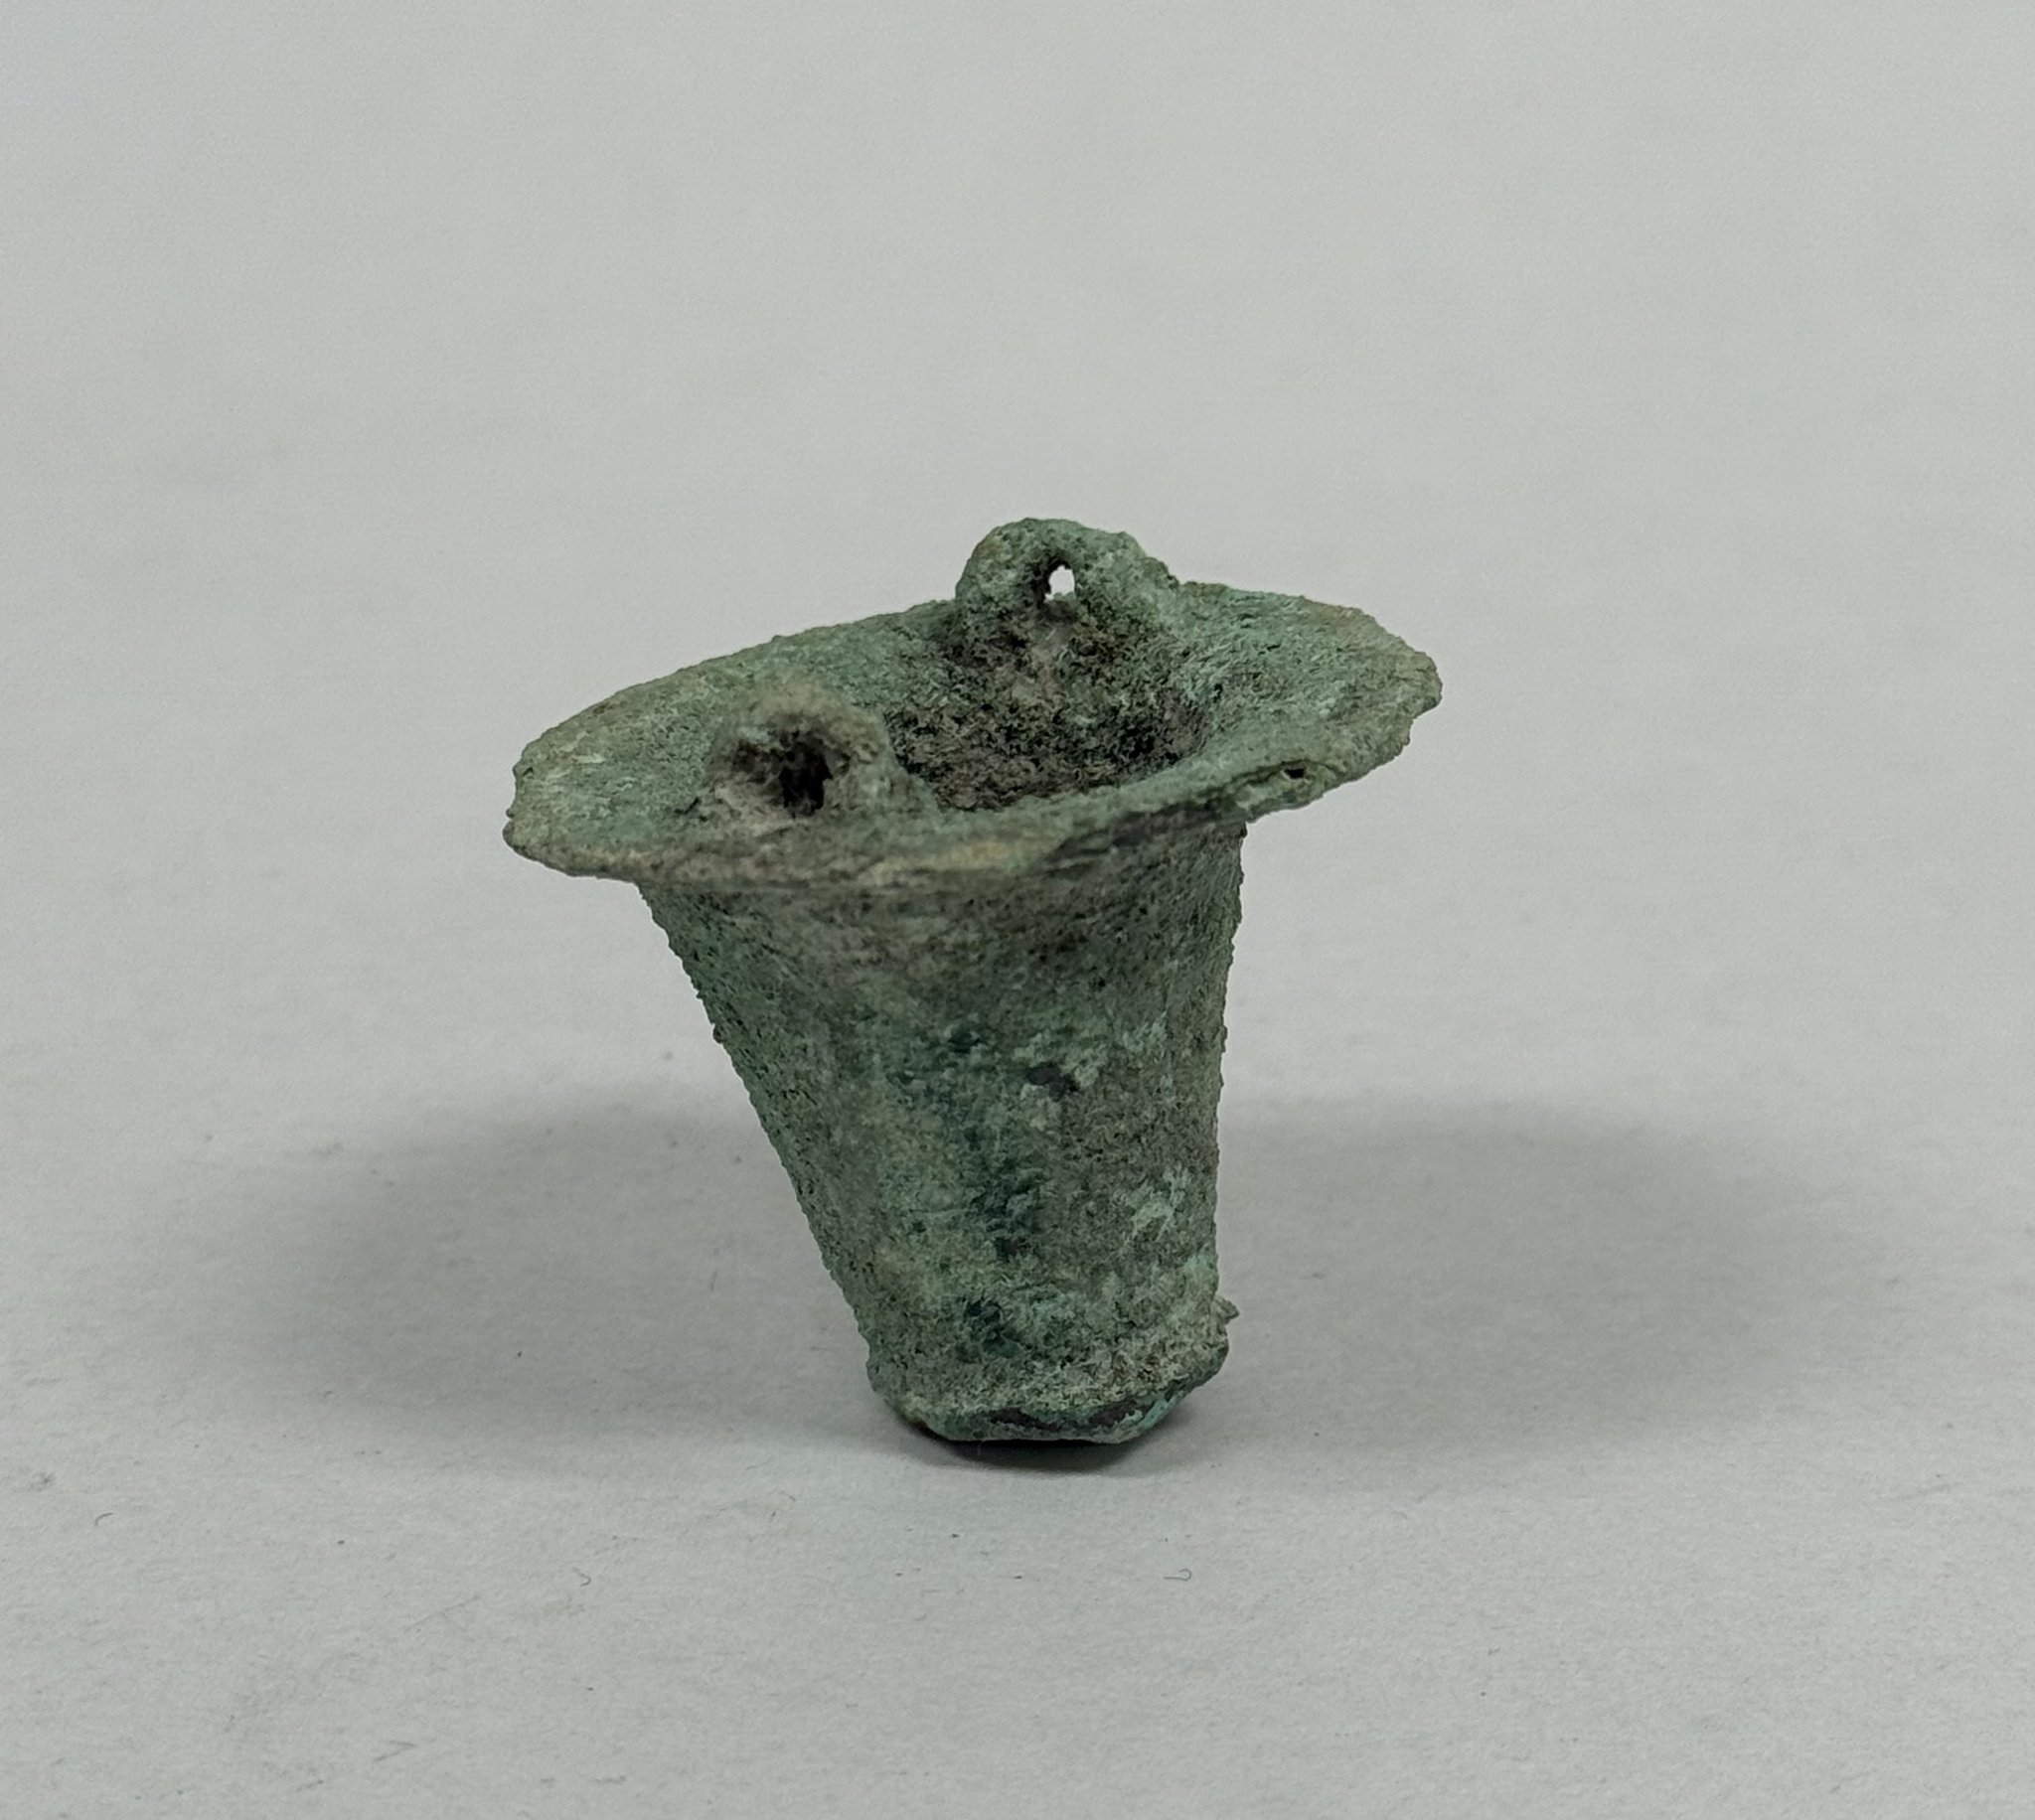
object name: cauldron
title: Miniature Cauldron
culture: indonesian, javanese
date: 500 BCE-300 CE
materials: bronze